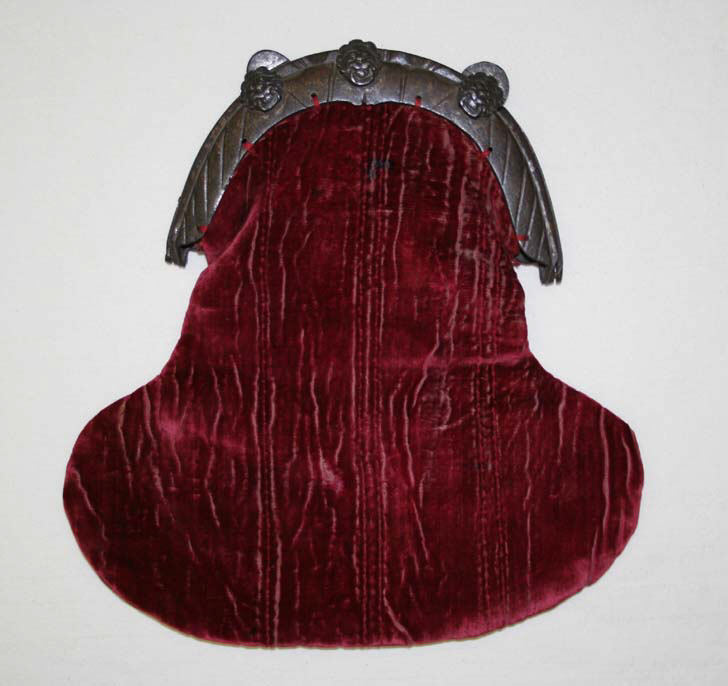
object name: purse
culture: german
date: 1501-1600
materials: iron, silk